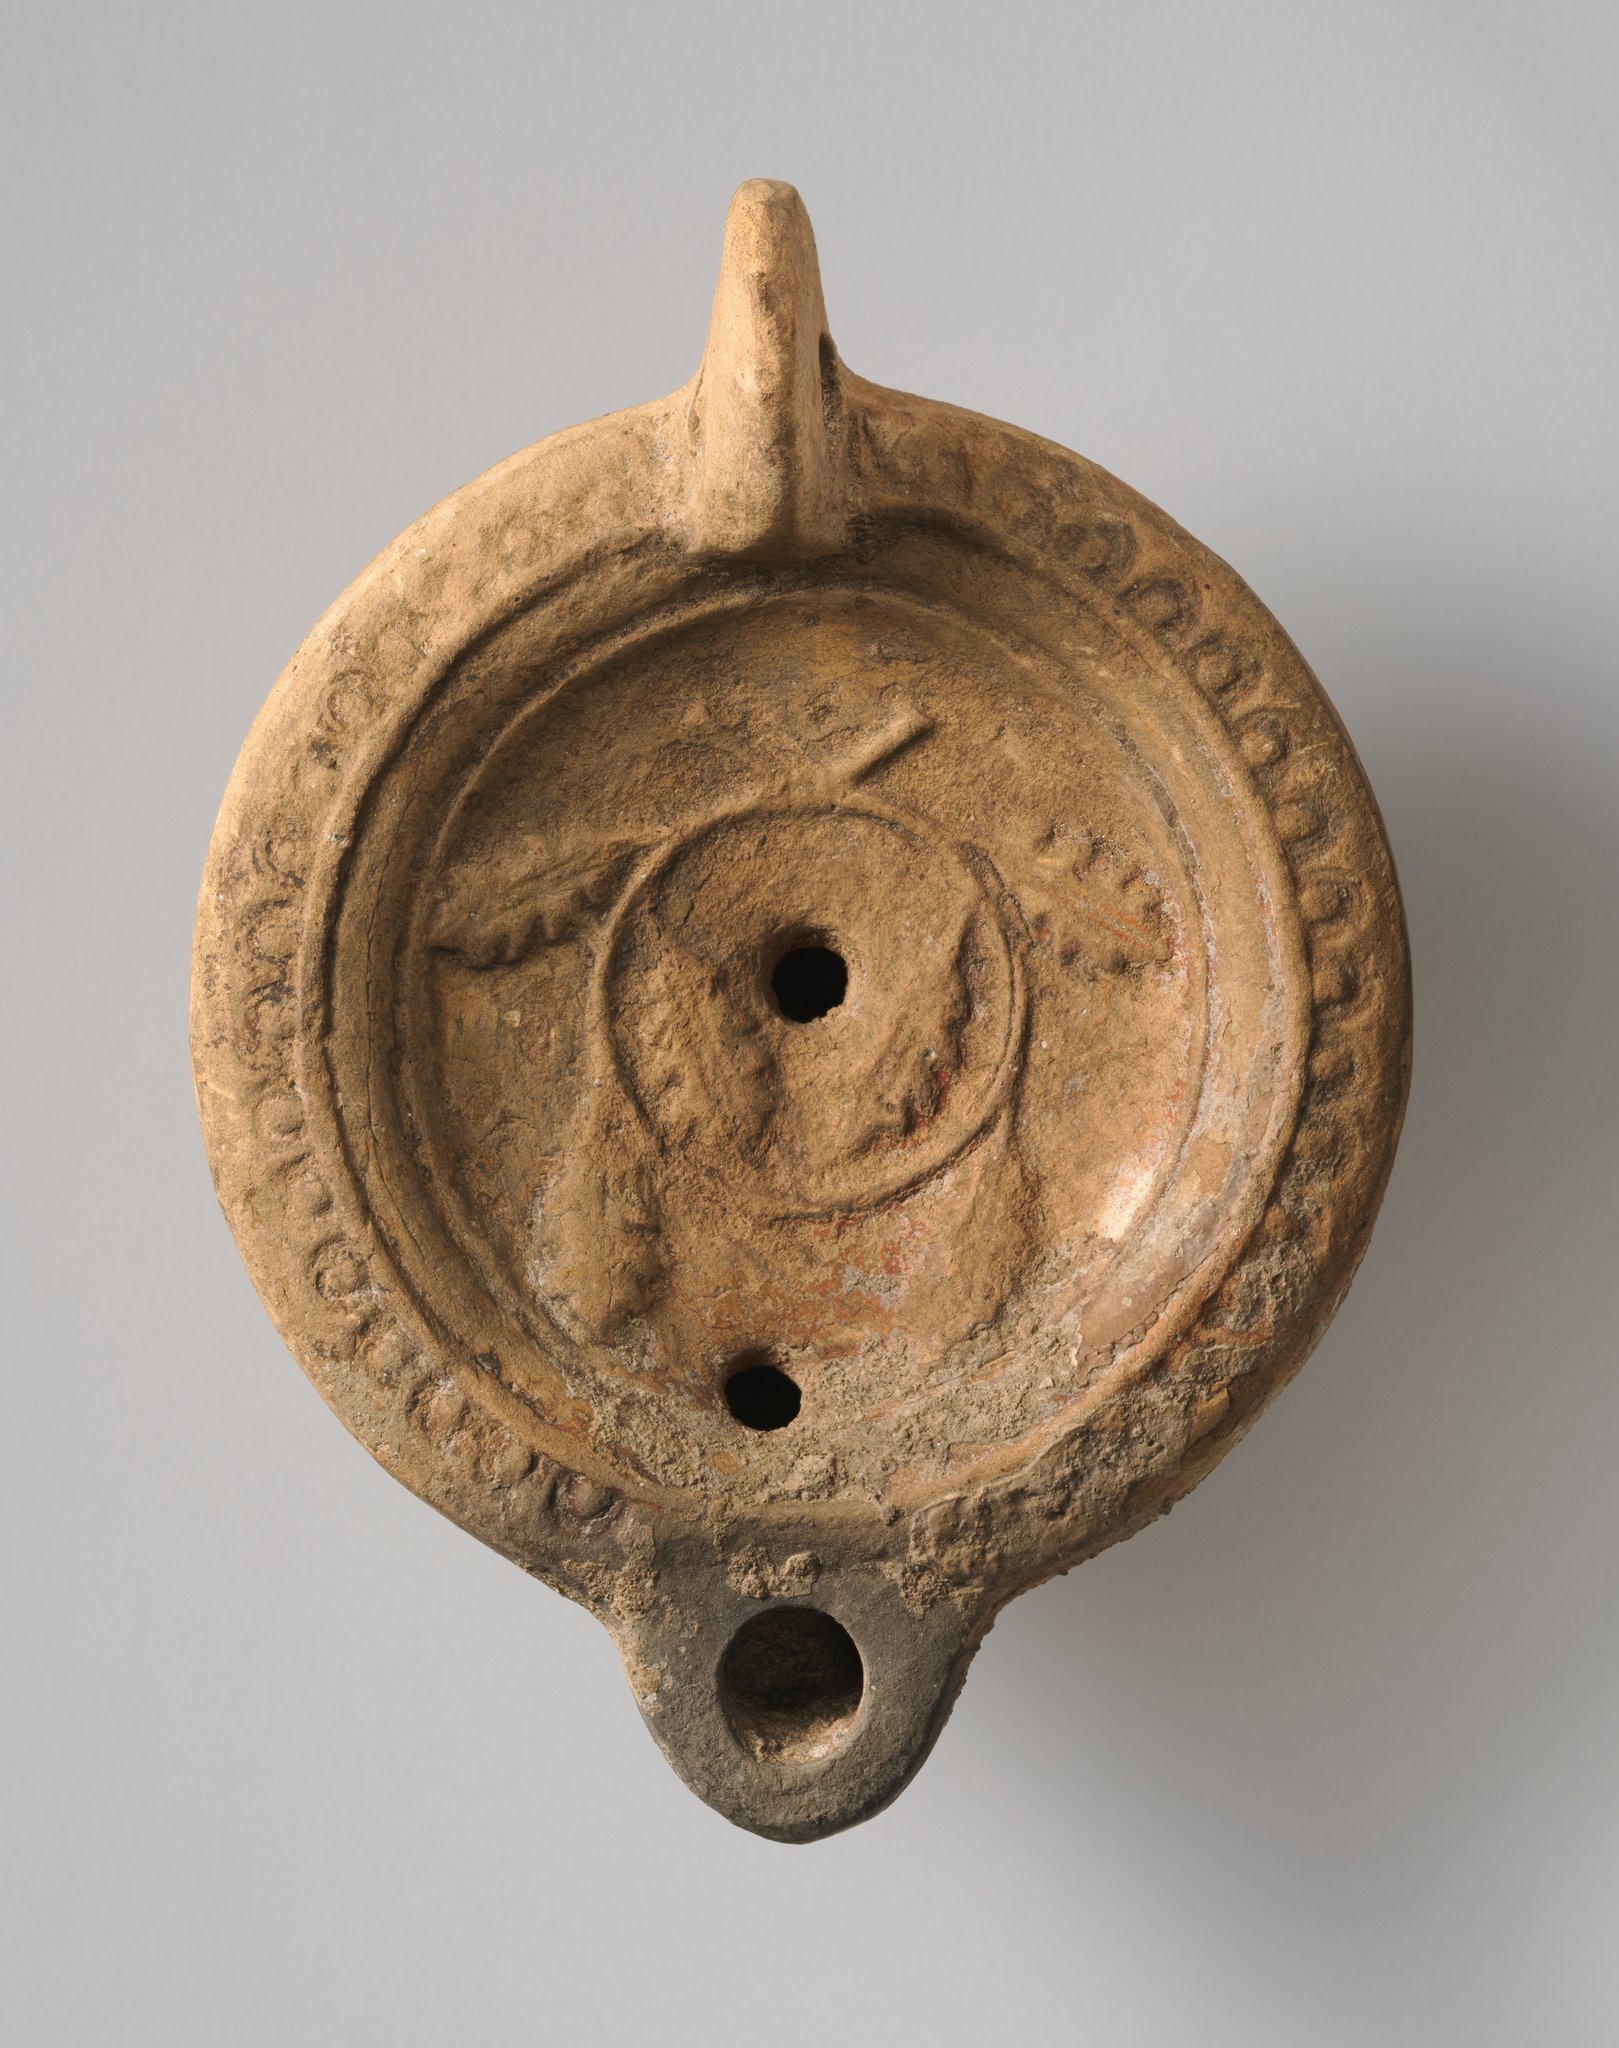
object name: lamp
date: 101-600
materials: earthenware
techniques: molding